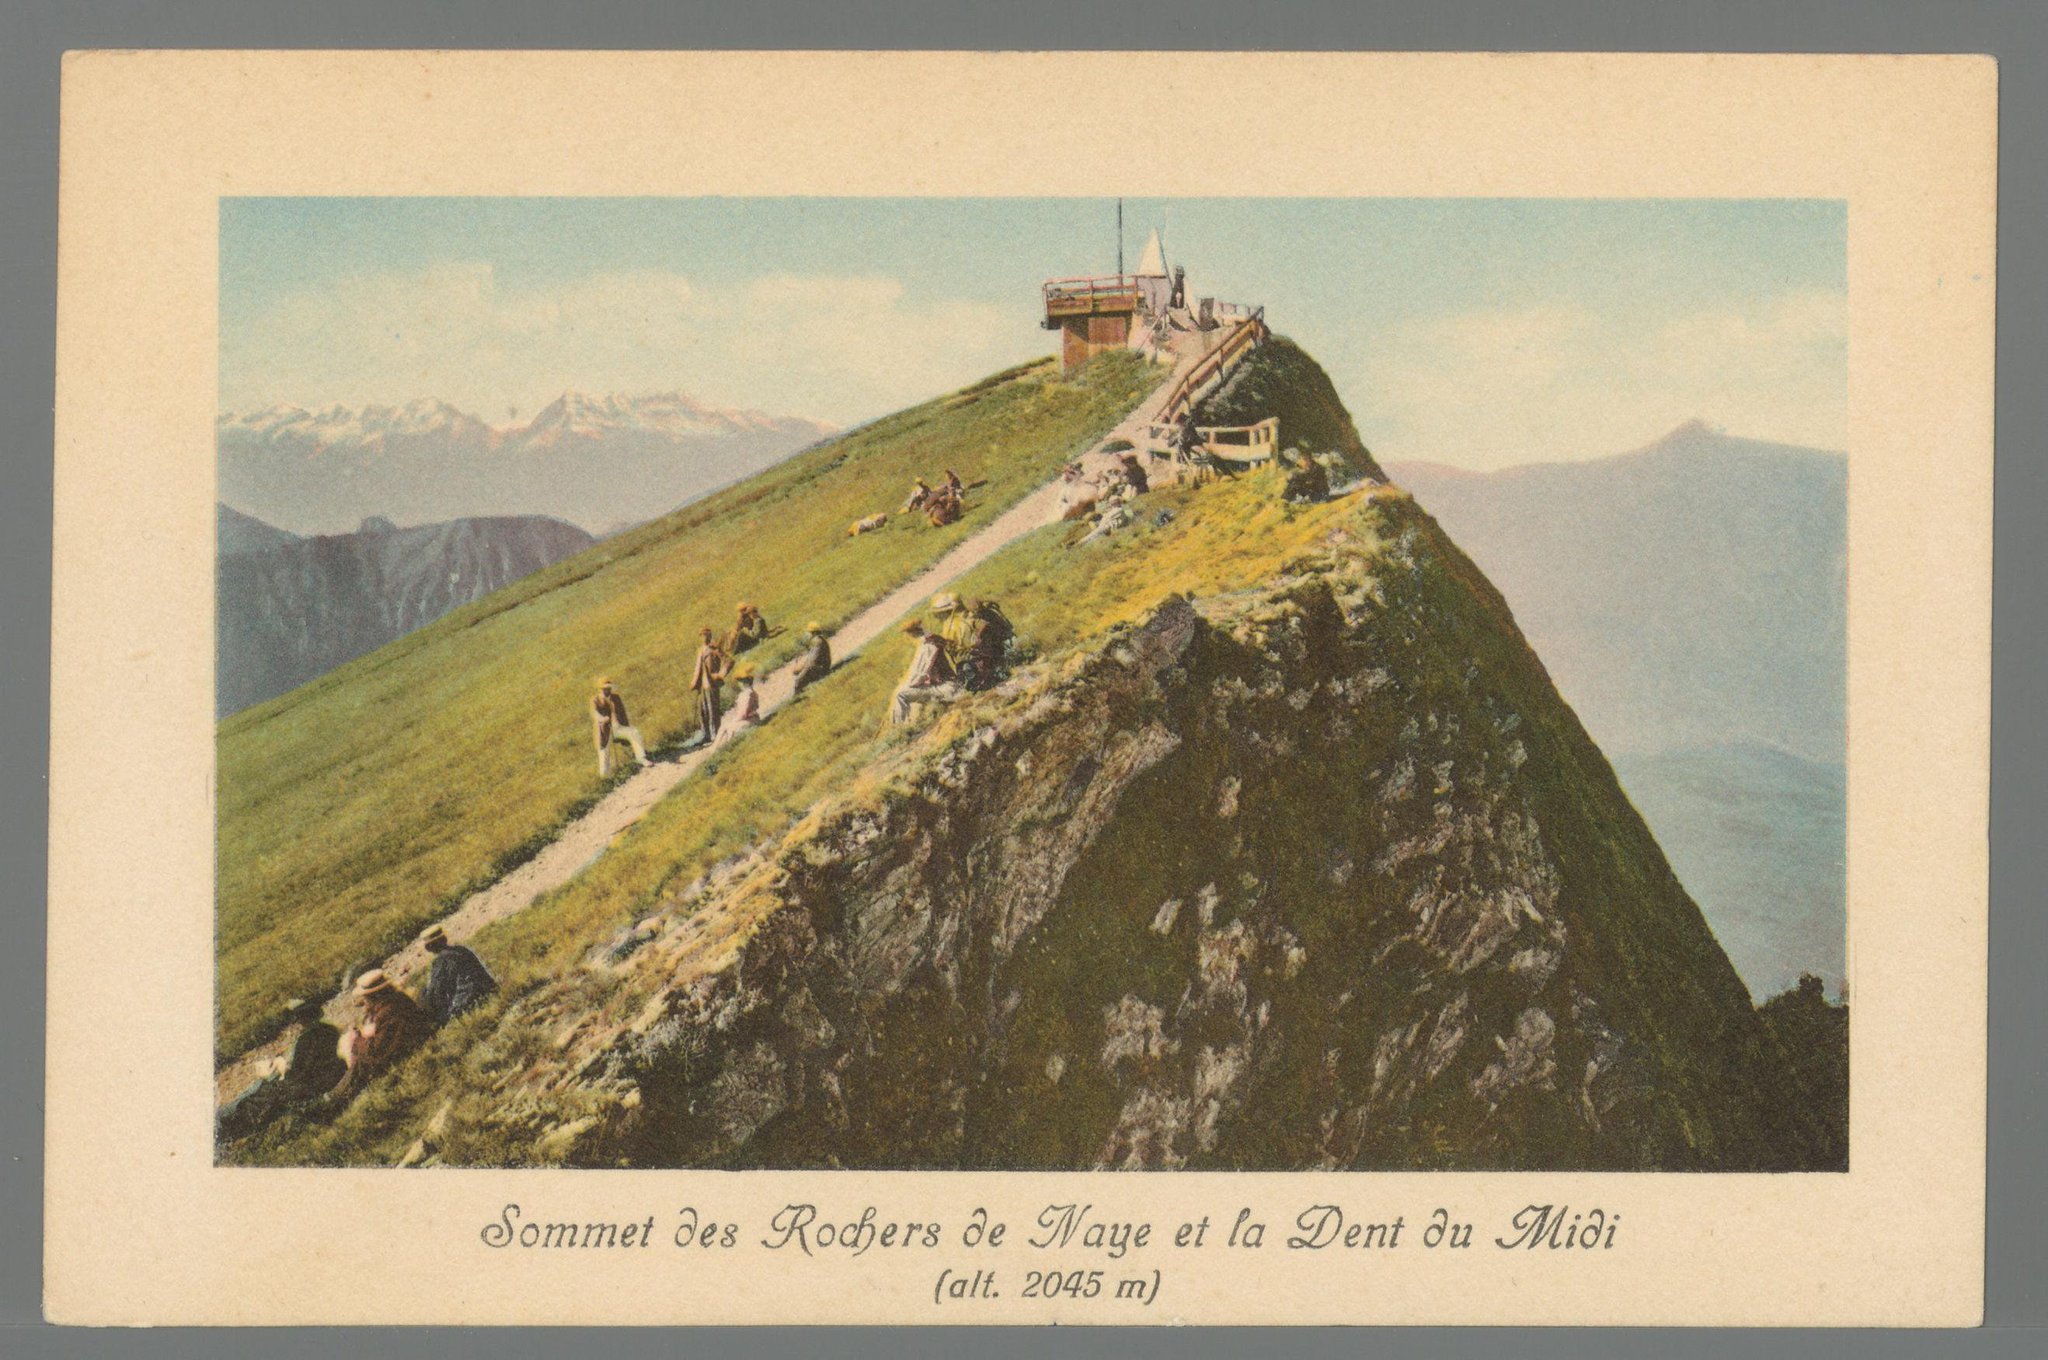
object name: photomechanical print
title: Sommet des Rochers de Naye et la Dent du Midi (alt. 2045 m)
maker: Anonymous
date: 1905-1920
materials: cardboard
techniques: photograph, lithograph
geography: rochers de naye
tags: mountain-range, snow peaks (+ landscape with figures, staffage)